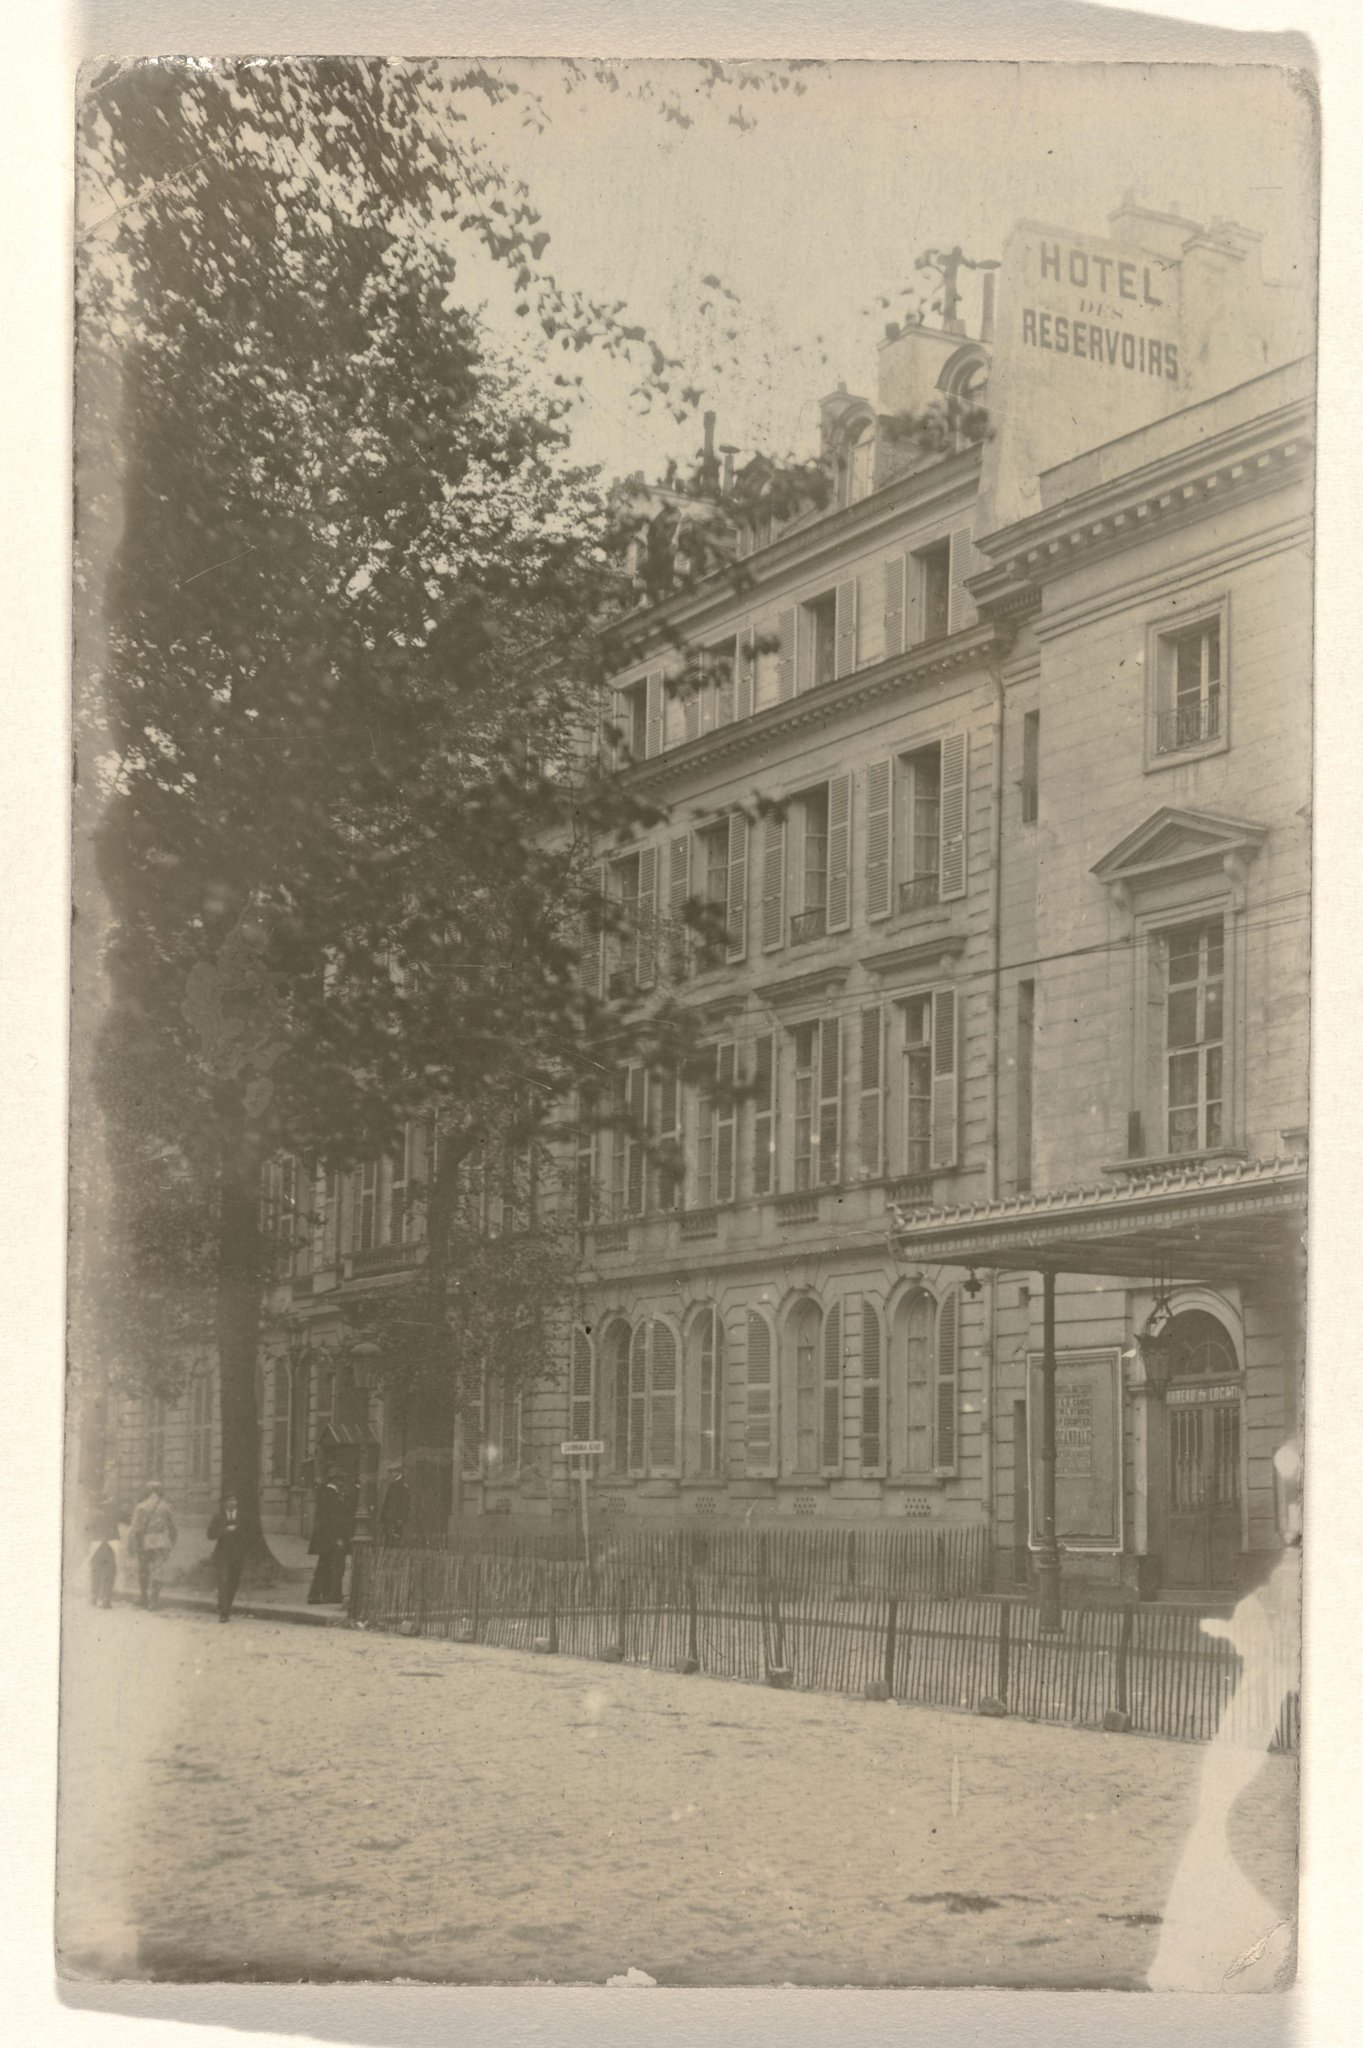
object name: photograph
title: Vooraanzicht van de flat waarin Eugen Wachenheimer verbleef tijdens de vredesonderhandelingen in Versailles na het einde van de Eerste Wereldoorlog, als voorkant van een brief van Eugen aan zijn zus Liesel Zürndorfer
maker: Anonymous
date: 1919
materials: photographic support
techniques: gelatin silver print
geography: versailles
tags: eugen wachenheimer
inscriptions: inscription: ‘no 4 24.4.19 Meine liebe Li Meine ... Einschreibsendung hoffe ich bei Dir; guten Appetit! Dies ist eine historische Karte. Zu nicht ... keine Zeit, de man selbst in ... arbeitslozen Momenten durch alles Möglich ... und in ... gestelten wird. Vielleicht ... ich und einige Andere (... die Helfe) morgen wieder bis an eites heim ... ... herzlich Eugen Abs Wachenheimer Deutsche Friedensdelegation Durch ... ... Frau Li Zürndorfer Stuttgart Gutenbergstr 22 3’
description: Vooraanzicht van de flat waarin Eugen Wachenheimer verbleef tijdens de vredesonderhandelingen in Versailles na het einde van de Eerste Wereldoorlog.